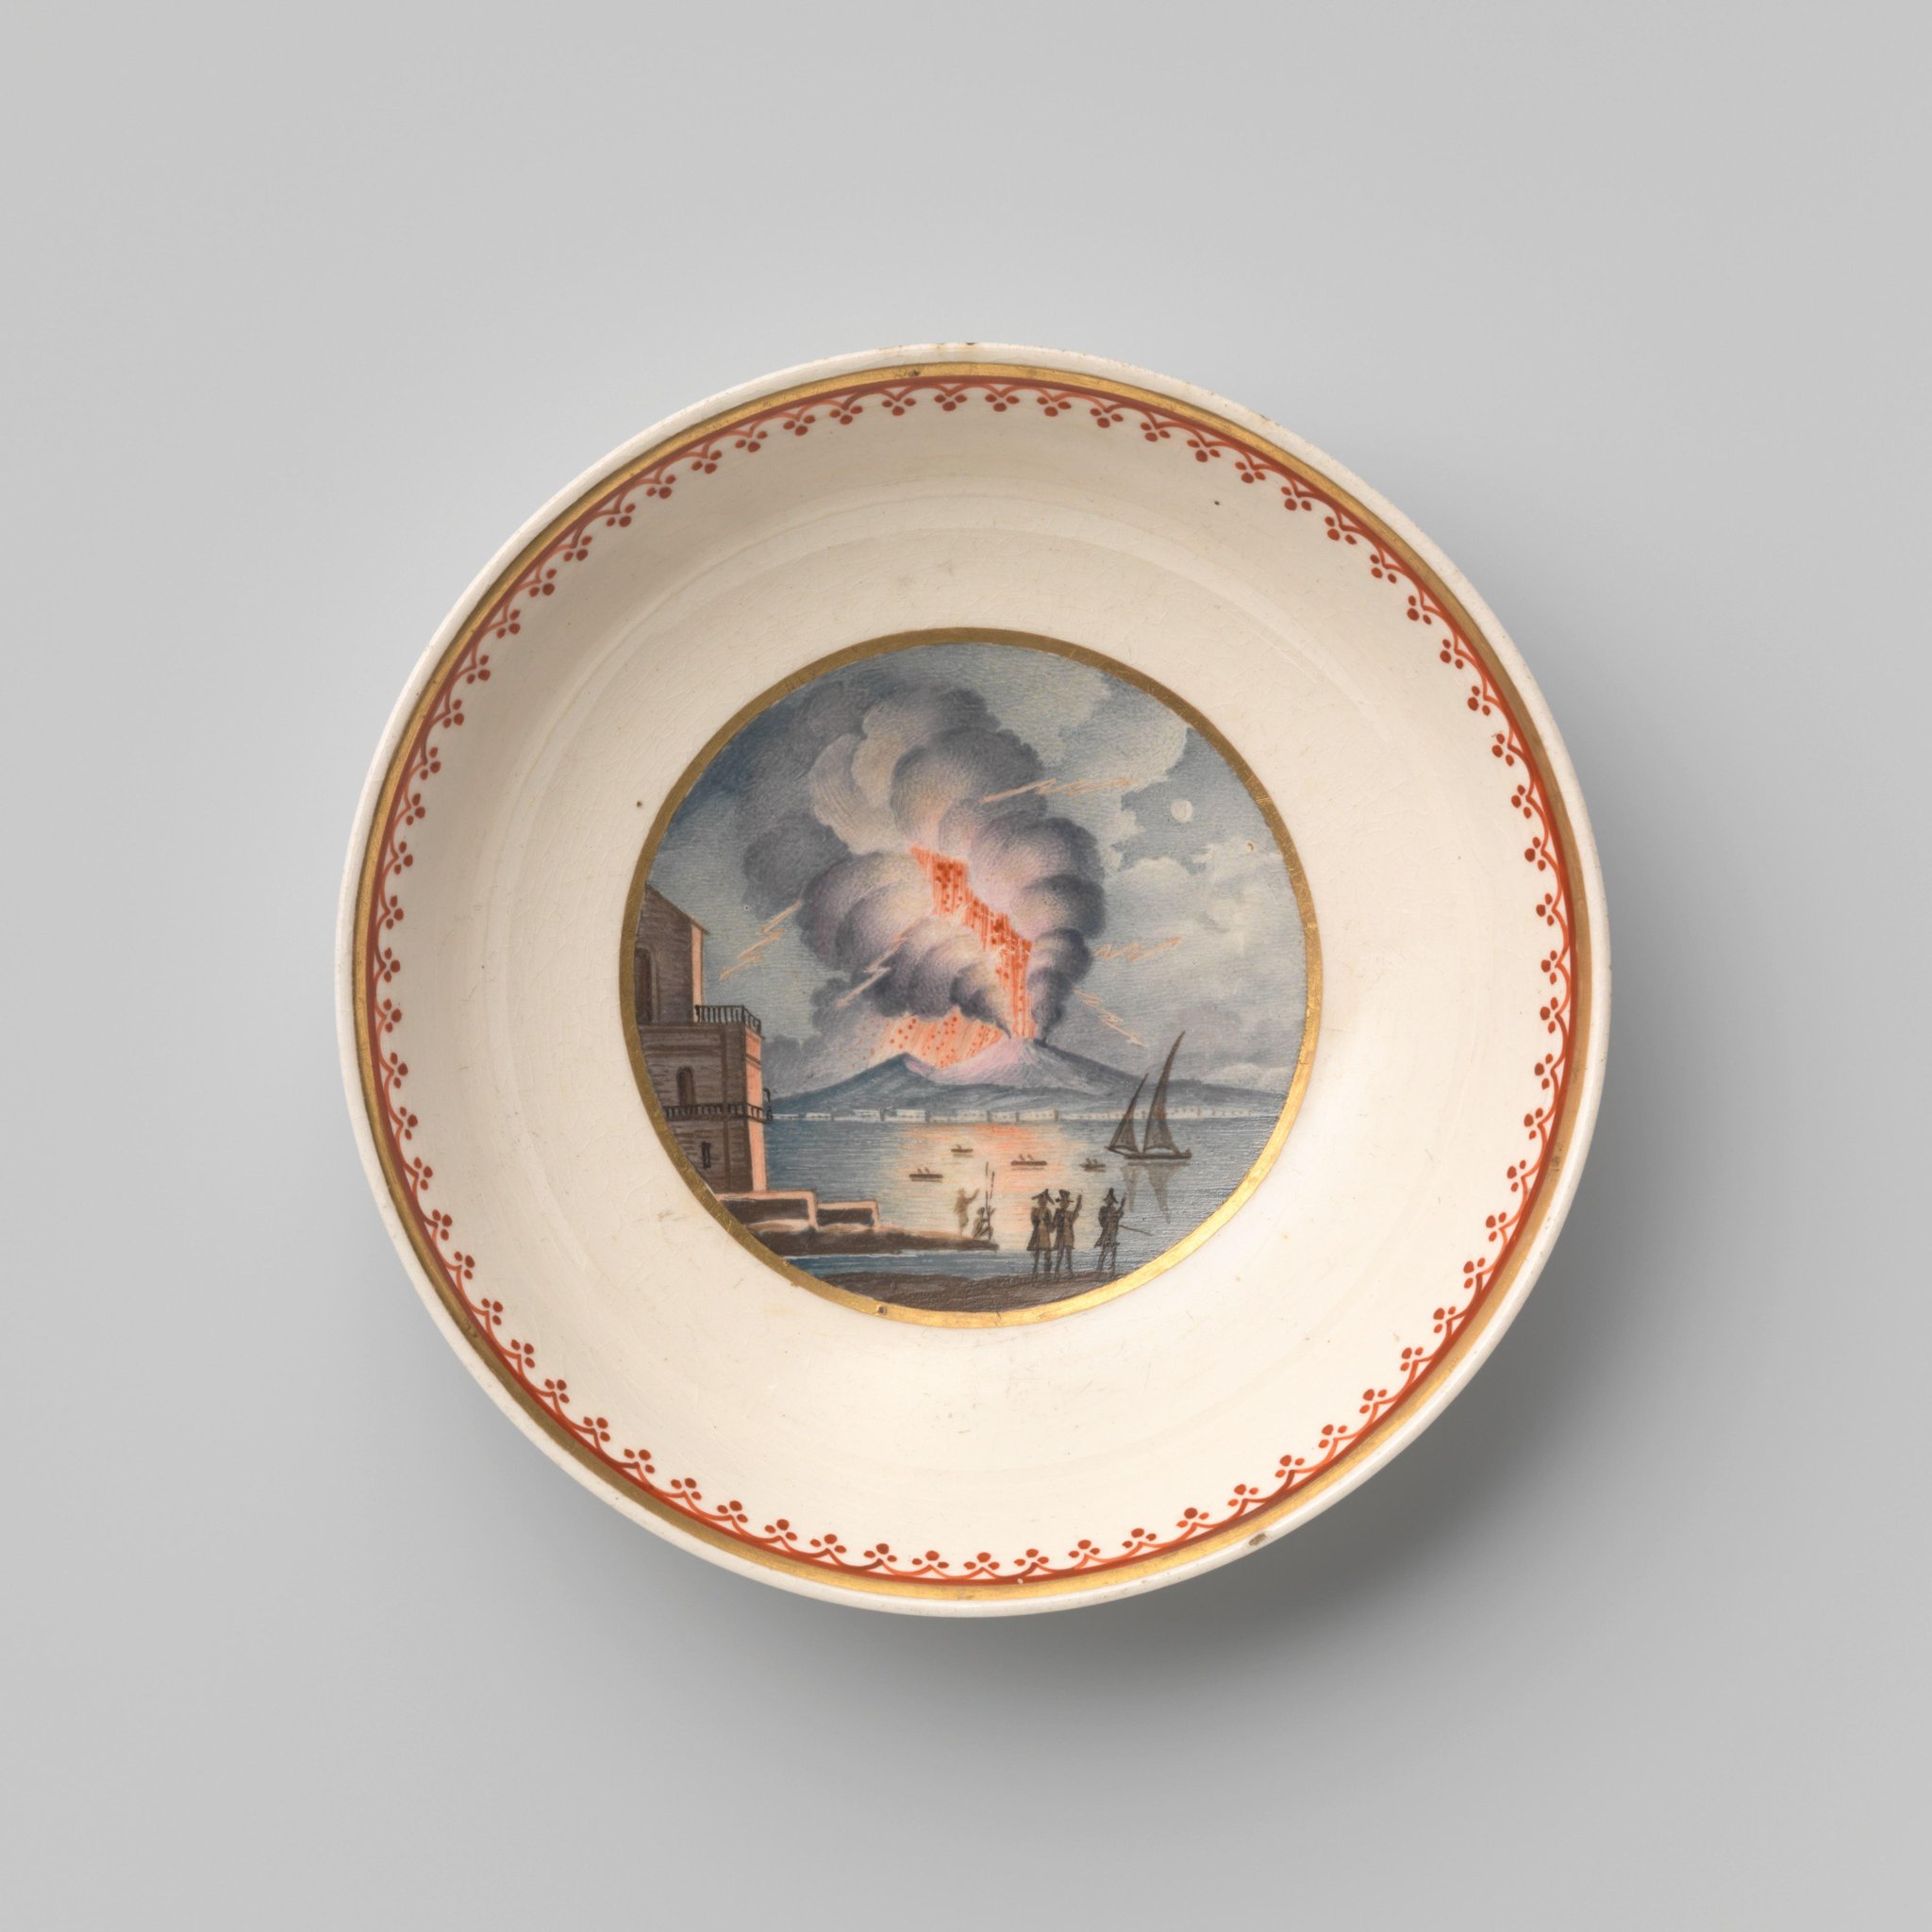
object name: platter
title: Saucer with an erupting vulcano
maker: Anonymous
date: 1775-1799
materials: glaze, gold, paint, porcelain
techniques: firing, gilding, turning, vitrification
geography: italy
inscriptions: inscription: ‘ERUZIONE DEL ANNO 1779’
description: Schotel van porselein (terraglia/creamware?), beschilderd op het glazuur in emailkleuren en goud. Op het plat een medaillon met een voorstelling van een vulkaanuitbarsting (Vesuvius). Op de voorgrond een gebouw en enkele personen die toekijken. Een aantal boten op het water. De binnenrand met een decoratieve band. Opschrift op de onderzijde met 'ERUZIONE DEL ANNO 1779'.